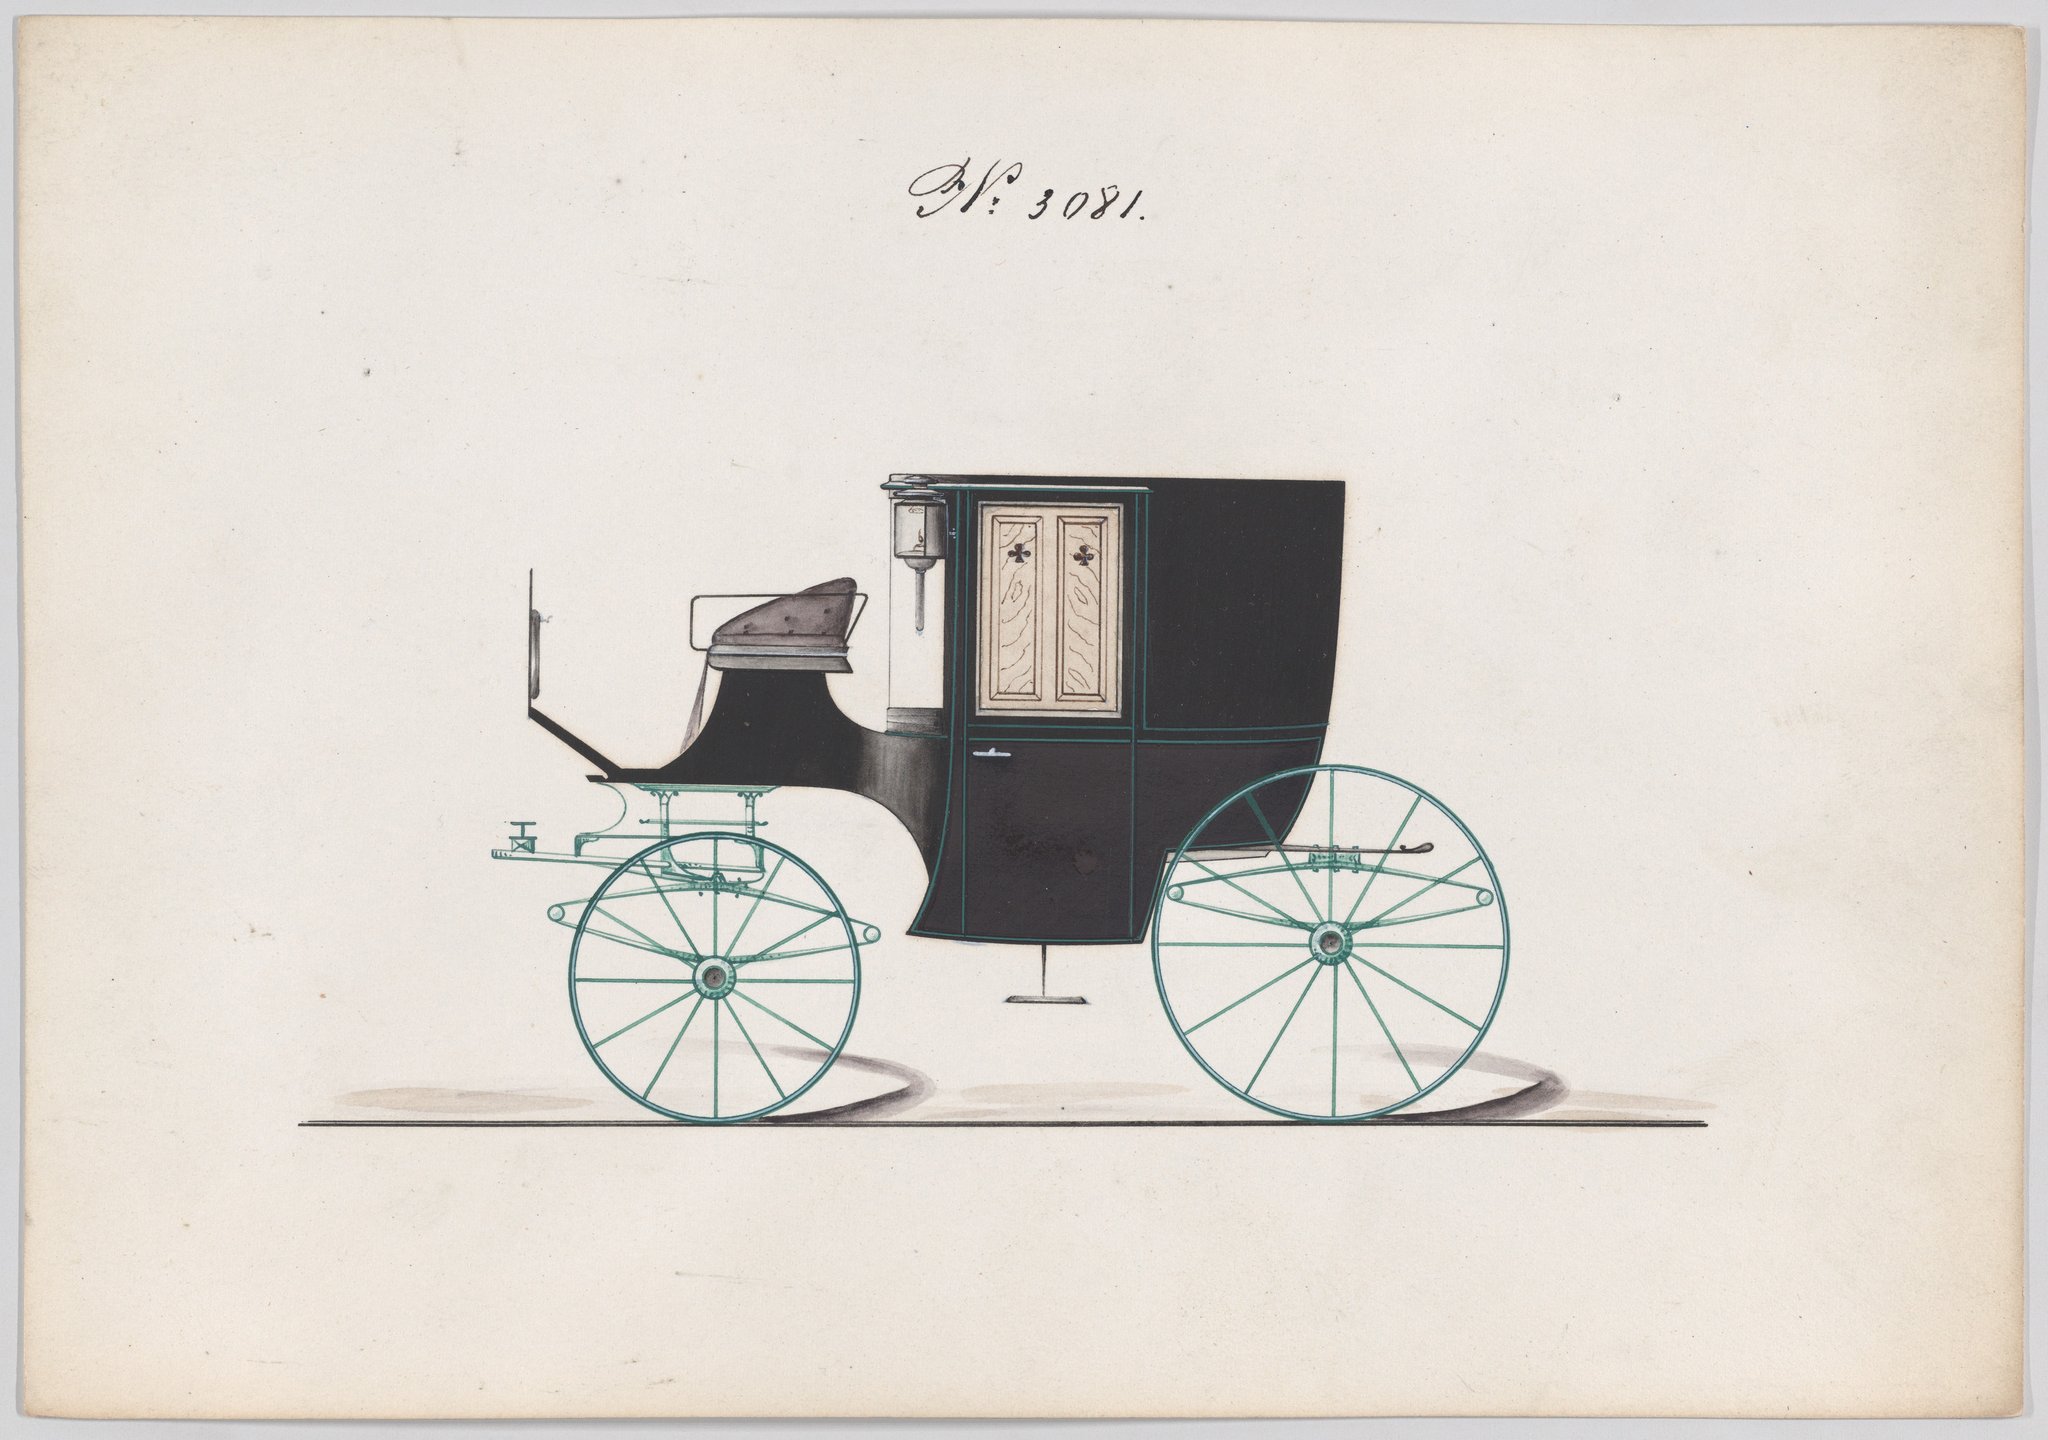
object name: drawing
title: Design for Coupé, no. 3081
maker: brewster & co.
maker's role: manufacturer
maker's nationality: american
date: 1874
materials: gouache, gum arabic, ink, watercolor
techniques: pen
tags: carriages